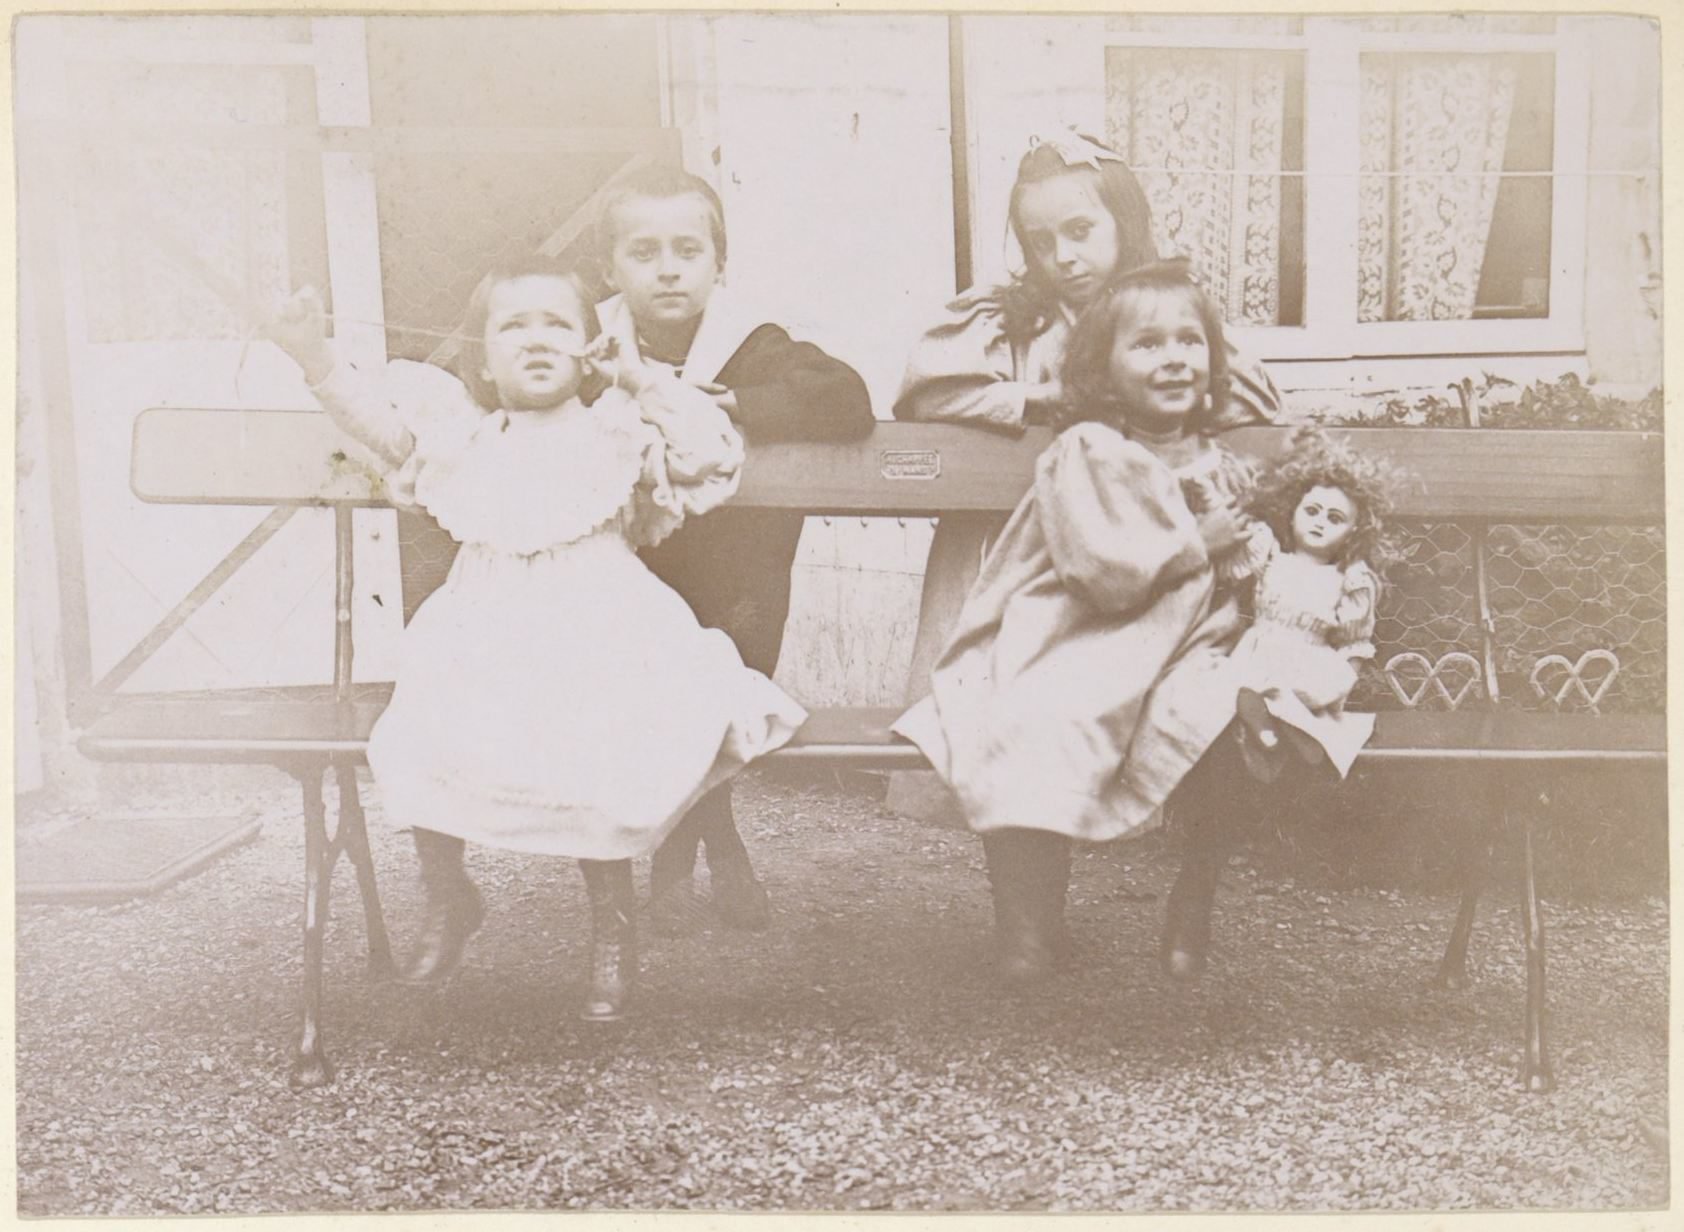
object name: photograph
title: Groepsportret van vier Franse kinderen bij een bank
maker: Anonymous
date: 1900-1910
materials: paper, photographic support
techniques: daylight paper print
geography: france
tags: child, (playing with) dolls, france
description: Onderdeel van Fotoalbum van een Franse amateurfotograaf met opnames van een familie, distilleerderij Delizy & Doistau Fils, het leger en bezienswaardigheden in Frankrijk.